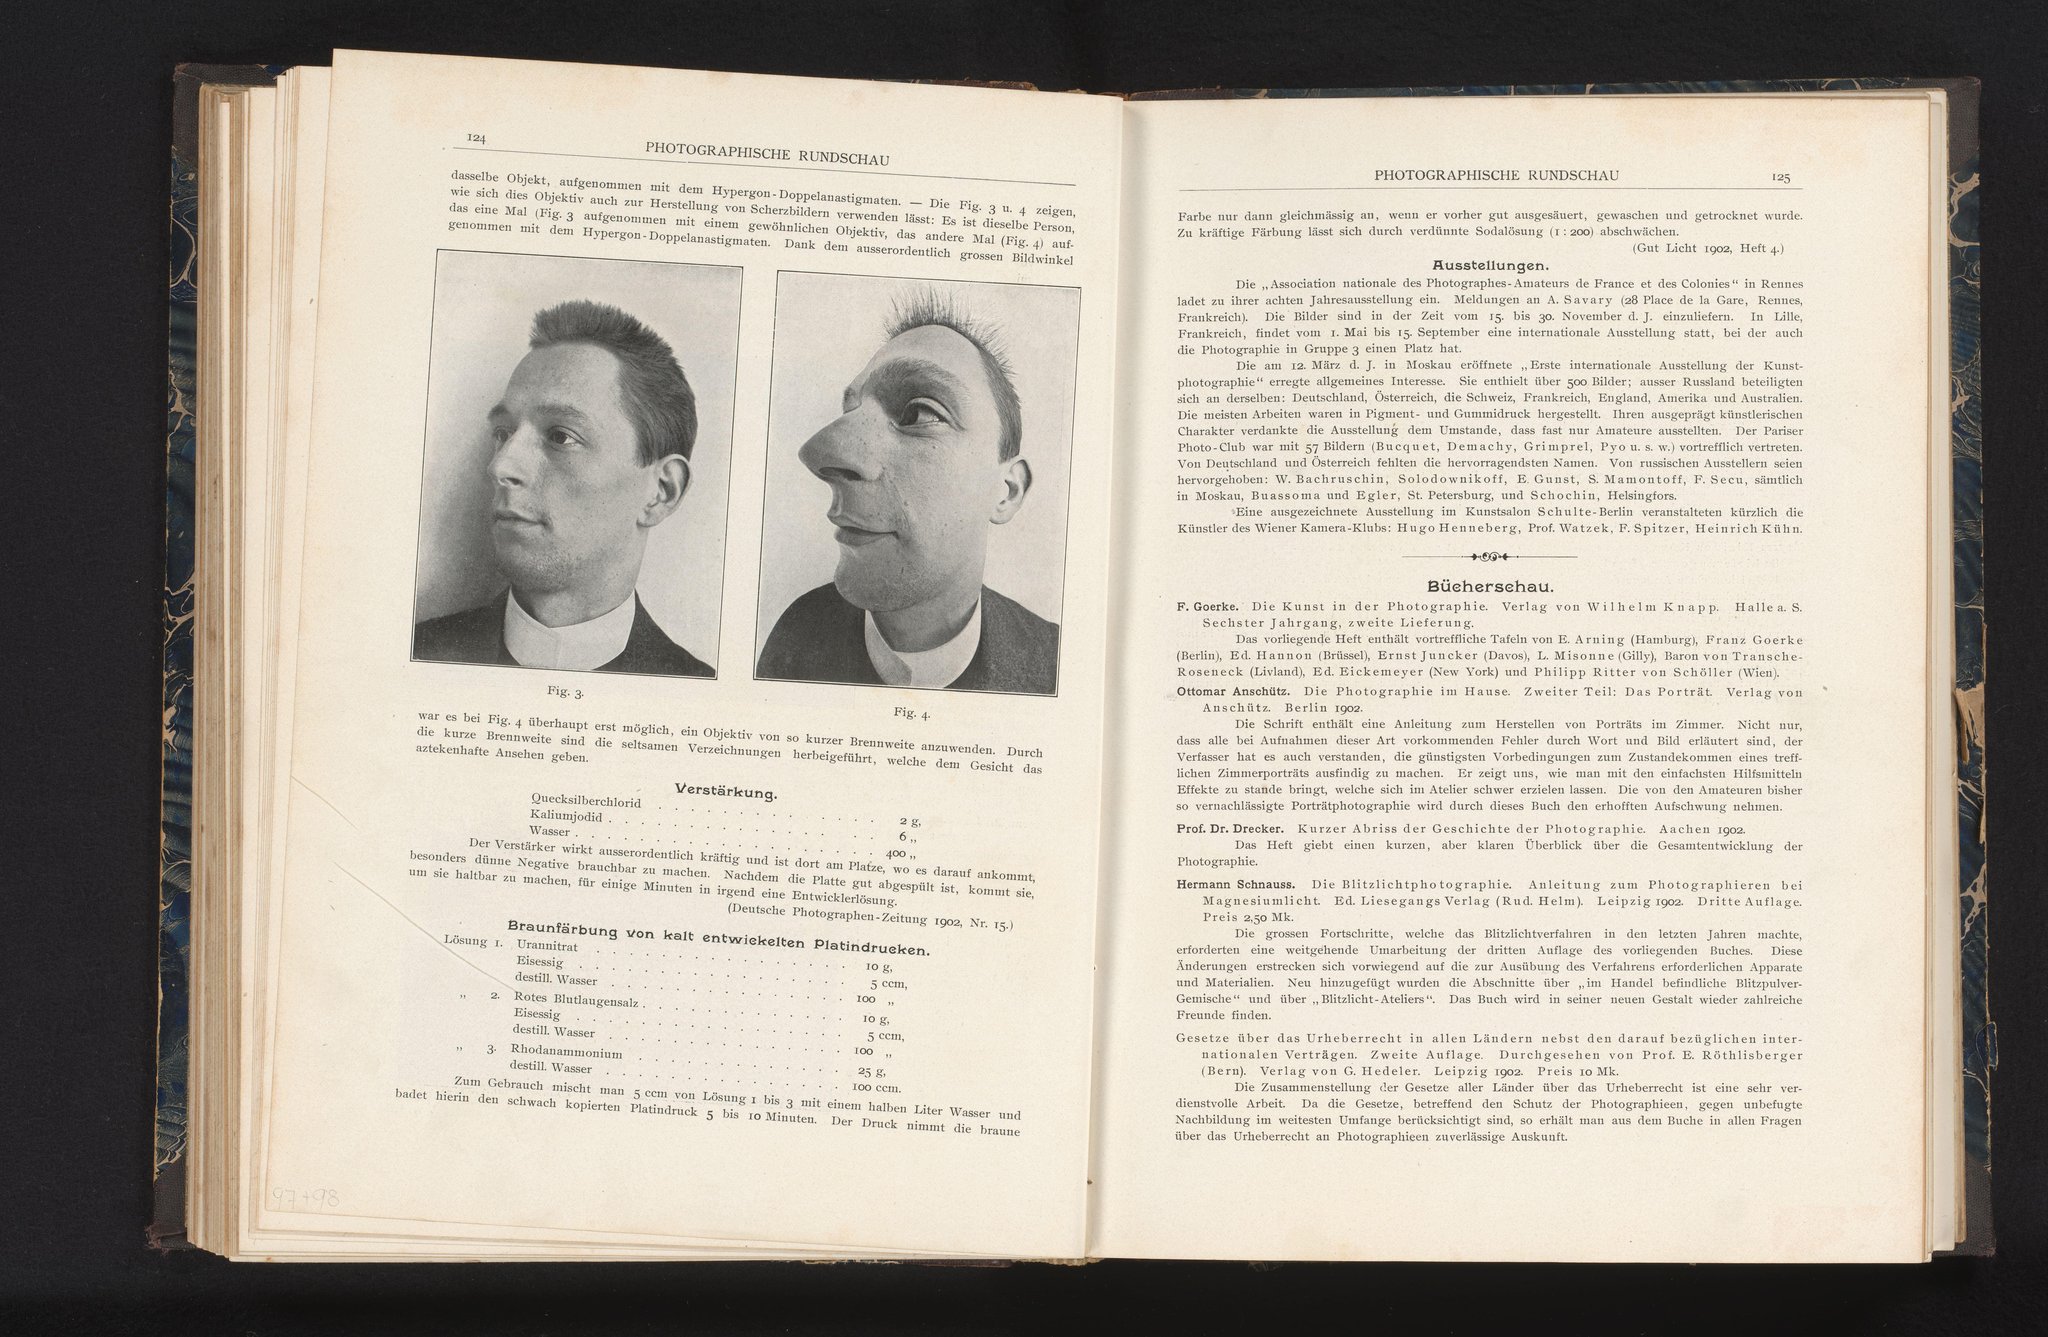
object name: photomechanical print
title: Portret van een onbekende man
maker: Anonymous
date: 1897-1902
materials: paper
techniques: autotype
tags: historical persons